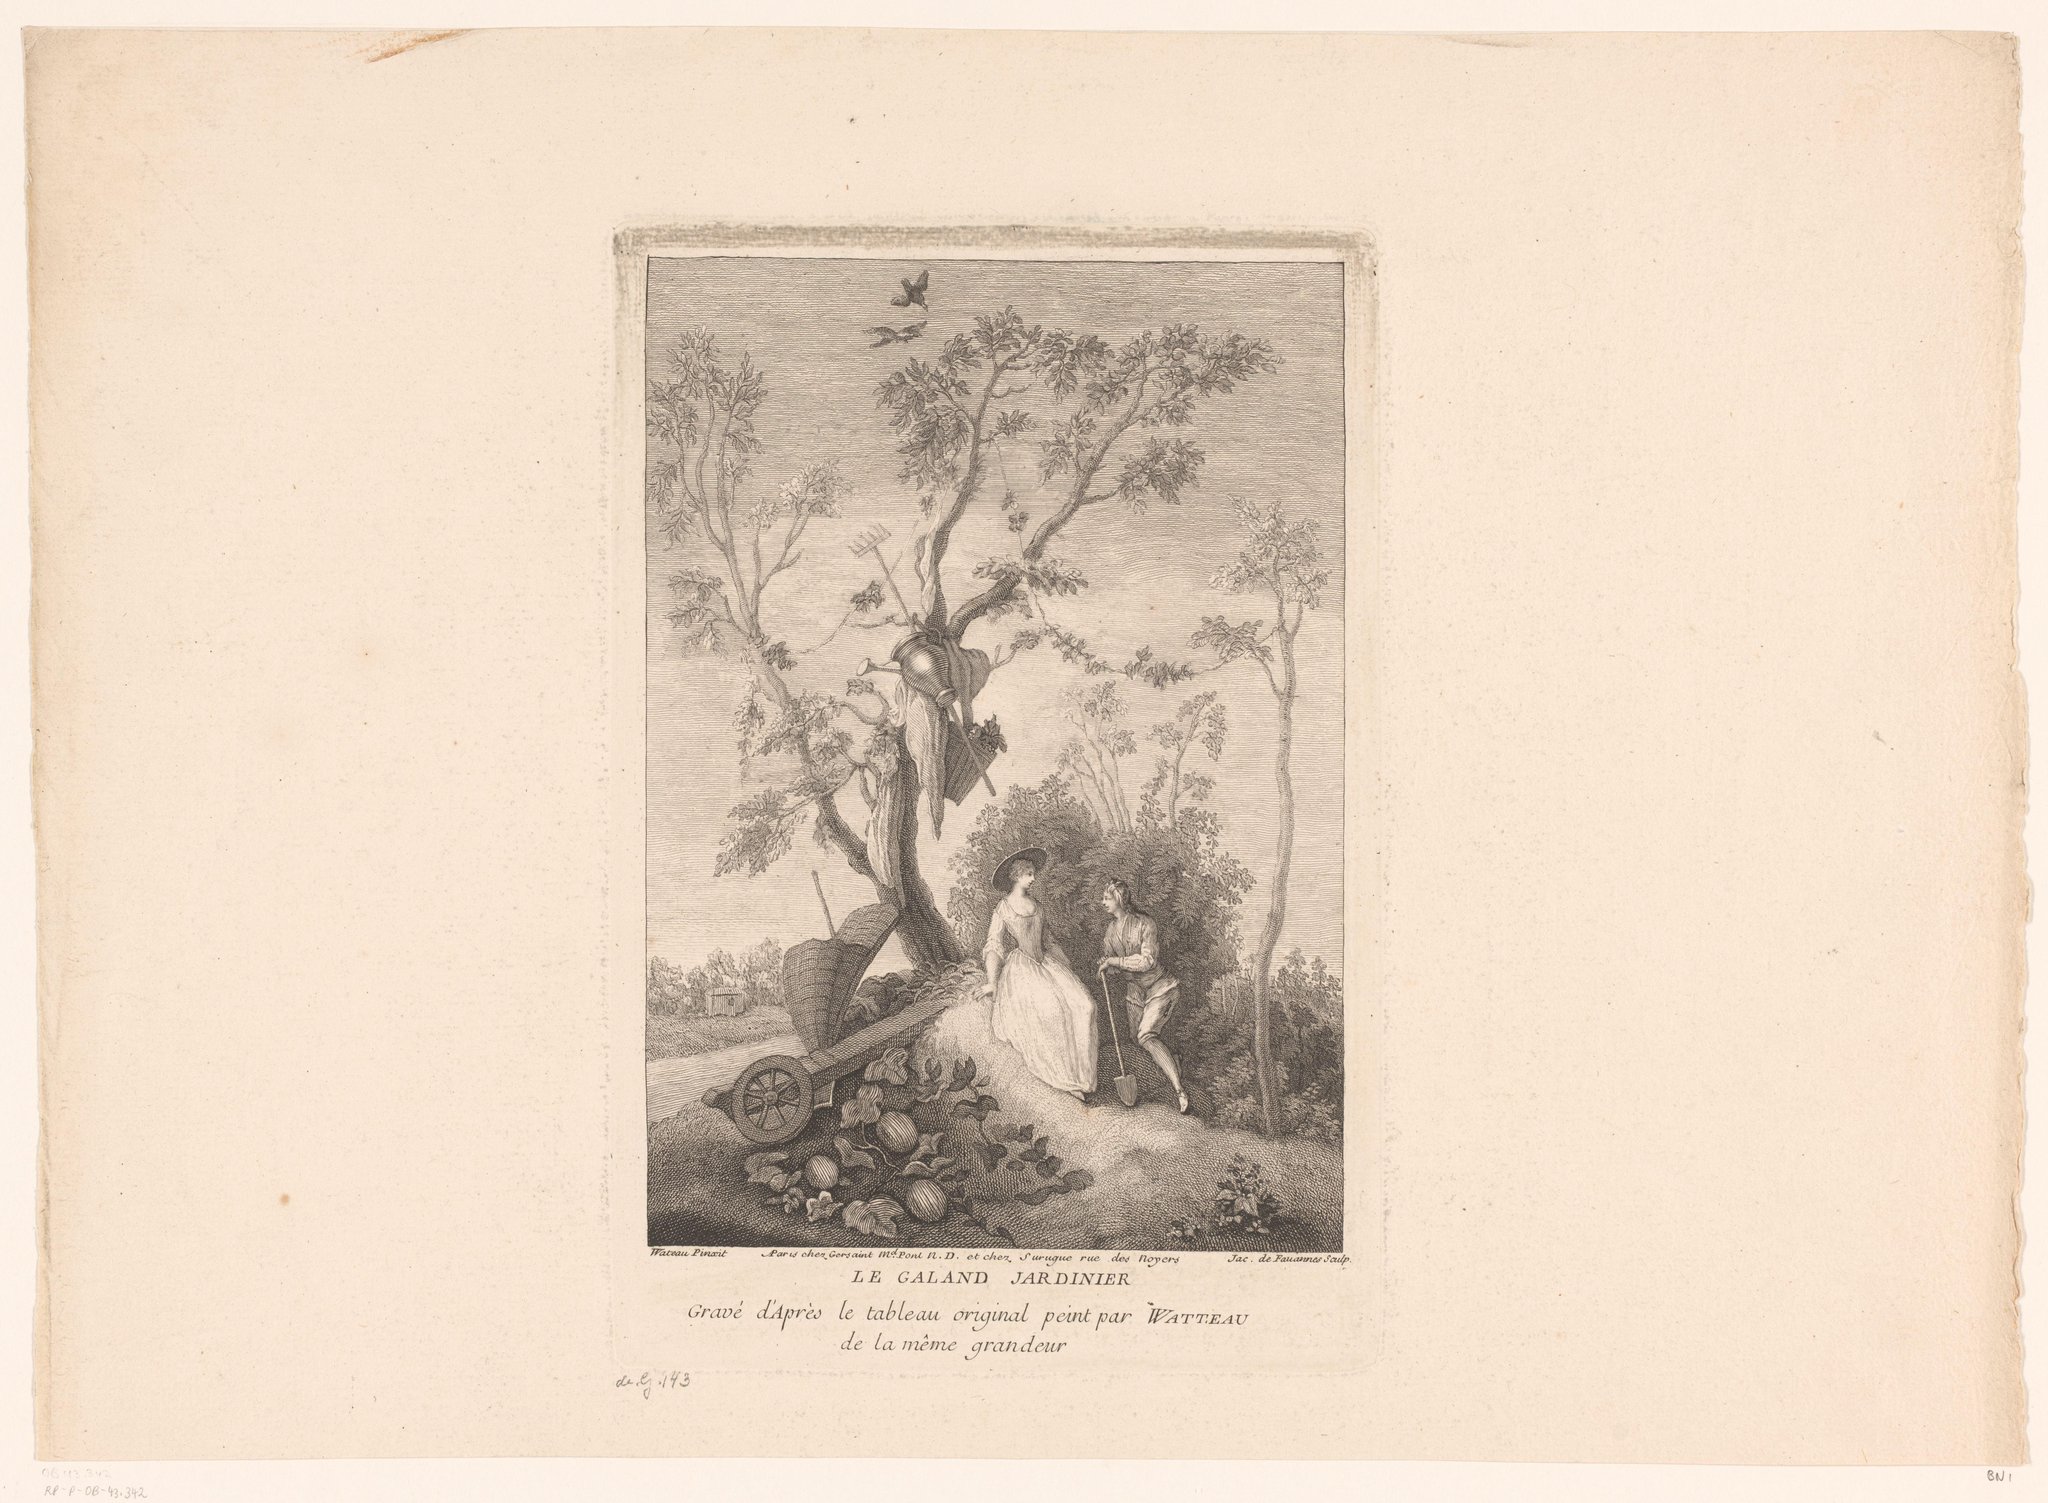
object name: print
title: Tuinier met jonge vrouw rustend in de tuin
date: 1729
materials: paper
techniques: engraving, etching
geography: france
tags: gardening, resting - bb - out of doors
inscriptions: collector's mark: Lugt 2228